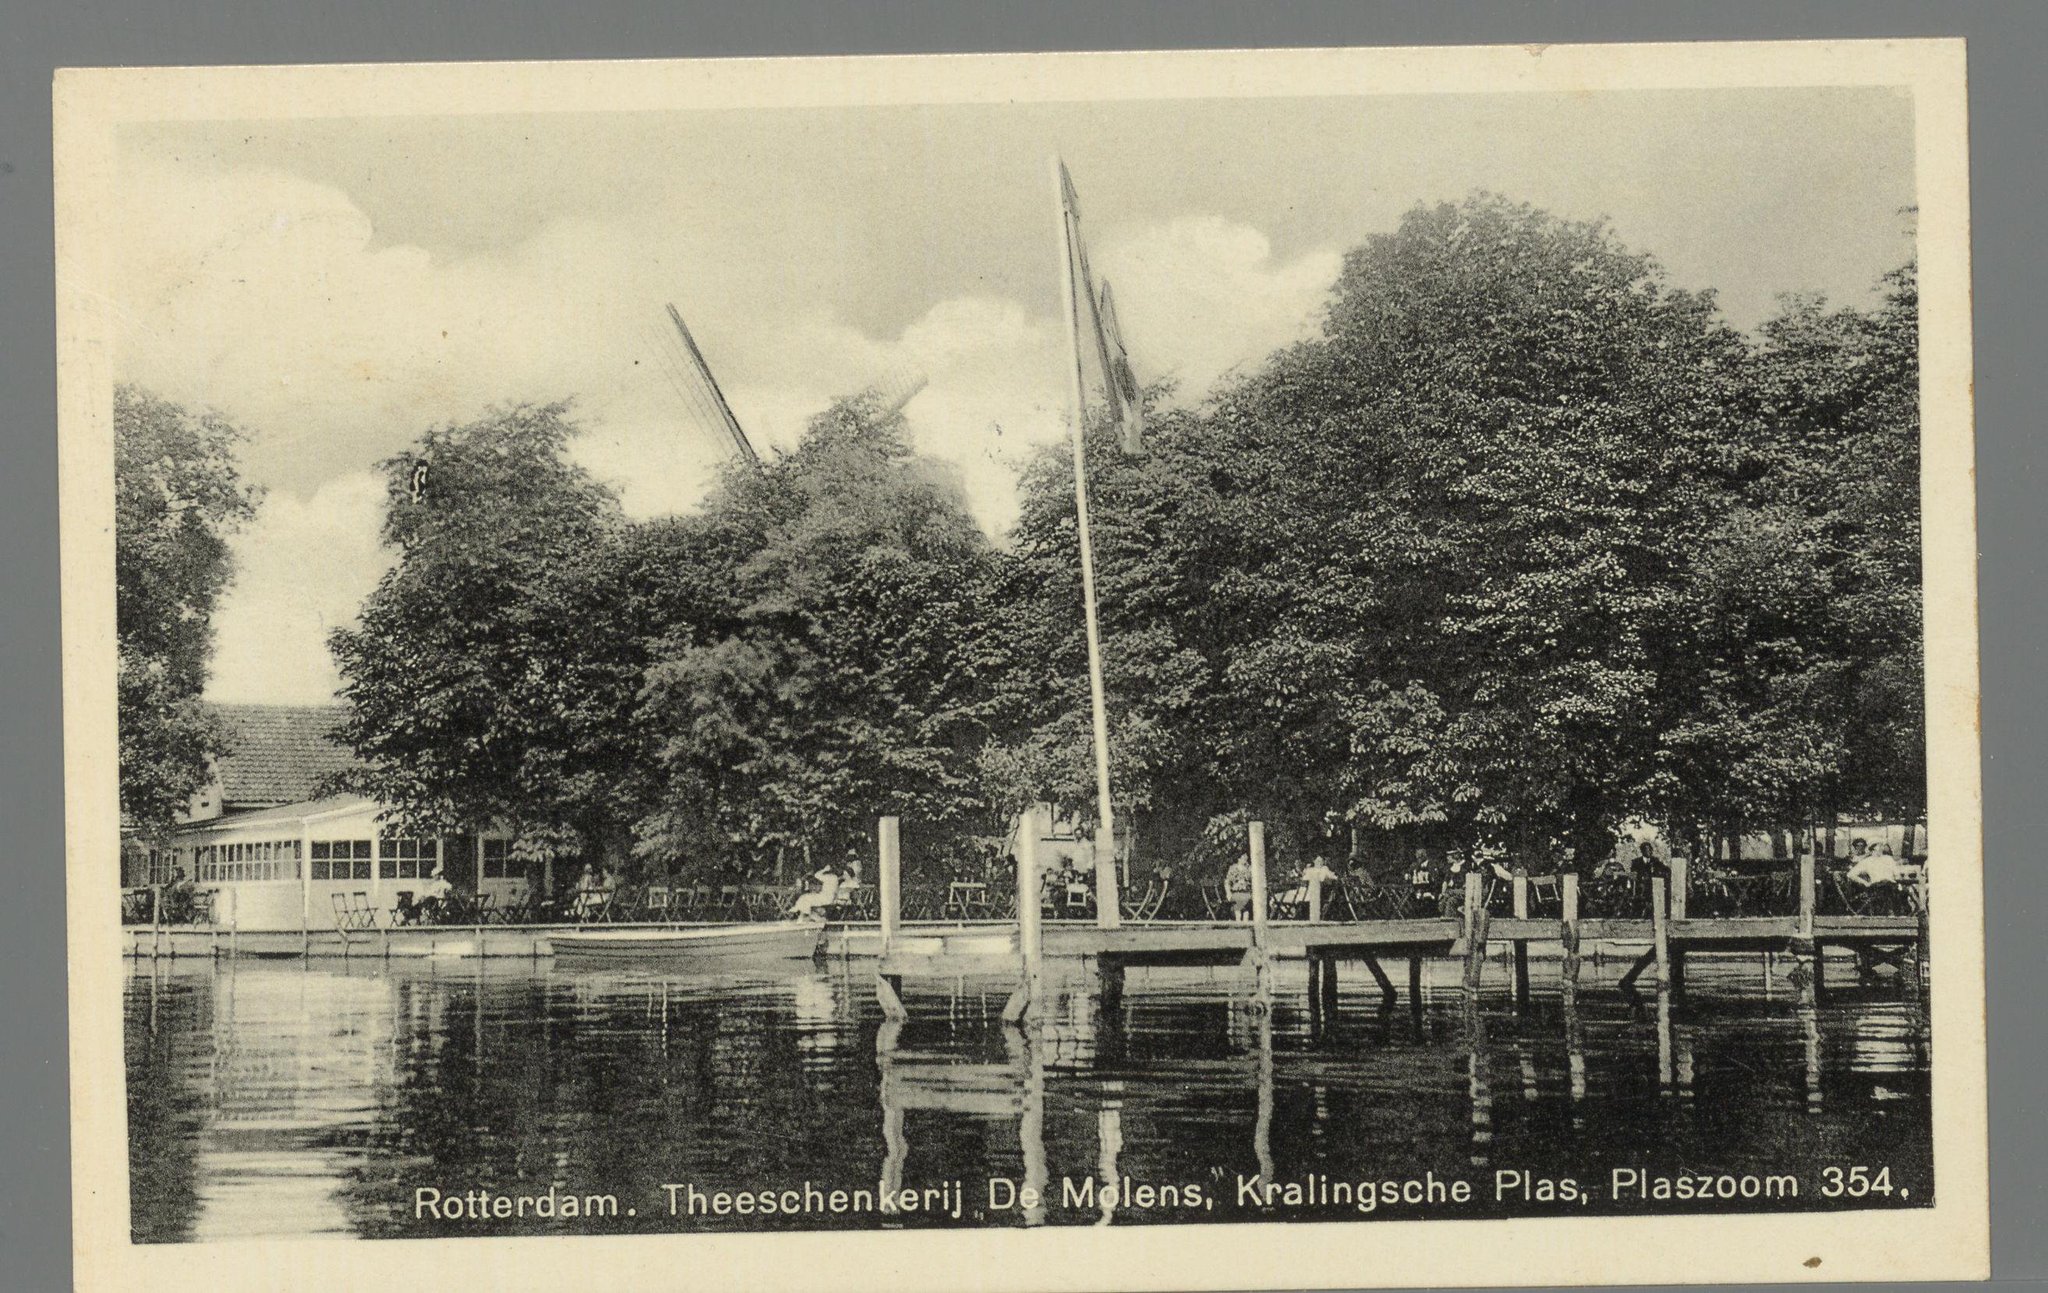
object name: photomechanical print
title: Rotterdam. Theeschenkerij "De Molens", Kralingsche Plas, Plaszoom 354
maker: Anonymous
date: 1913-1938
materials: cardboard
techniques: photograph, writing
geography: rotterdam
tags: lake, tea garden, garden restaurant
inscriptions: postage stamp